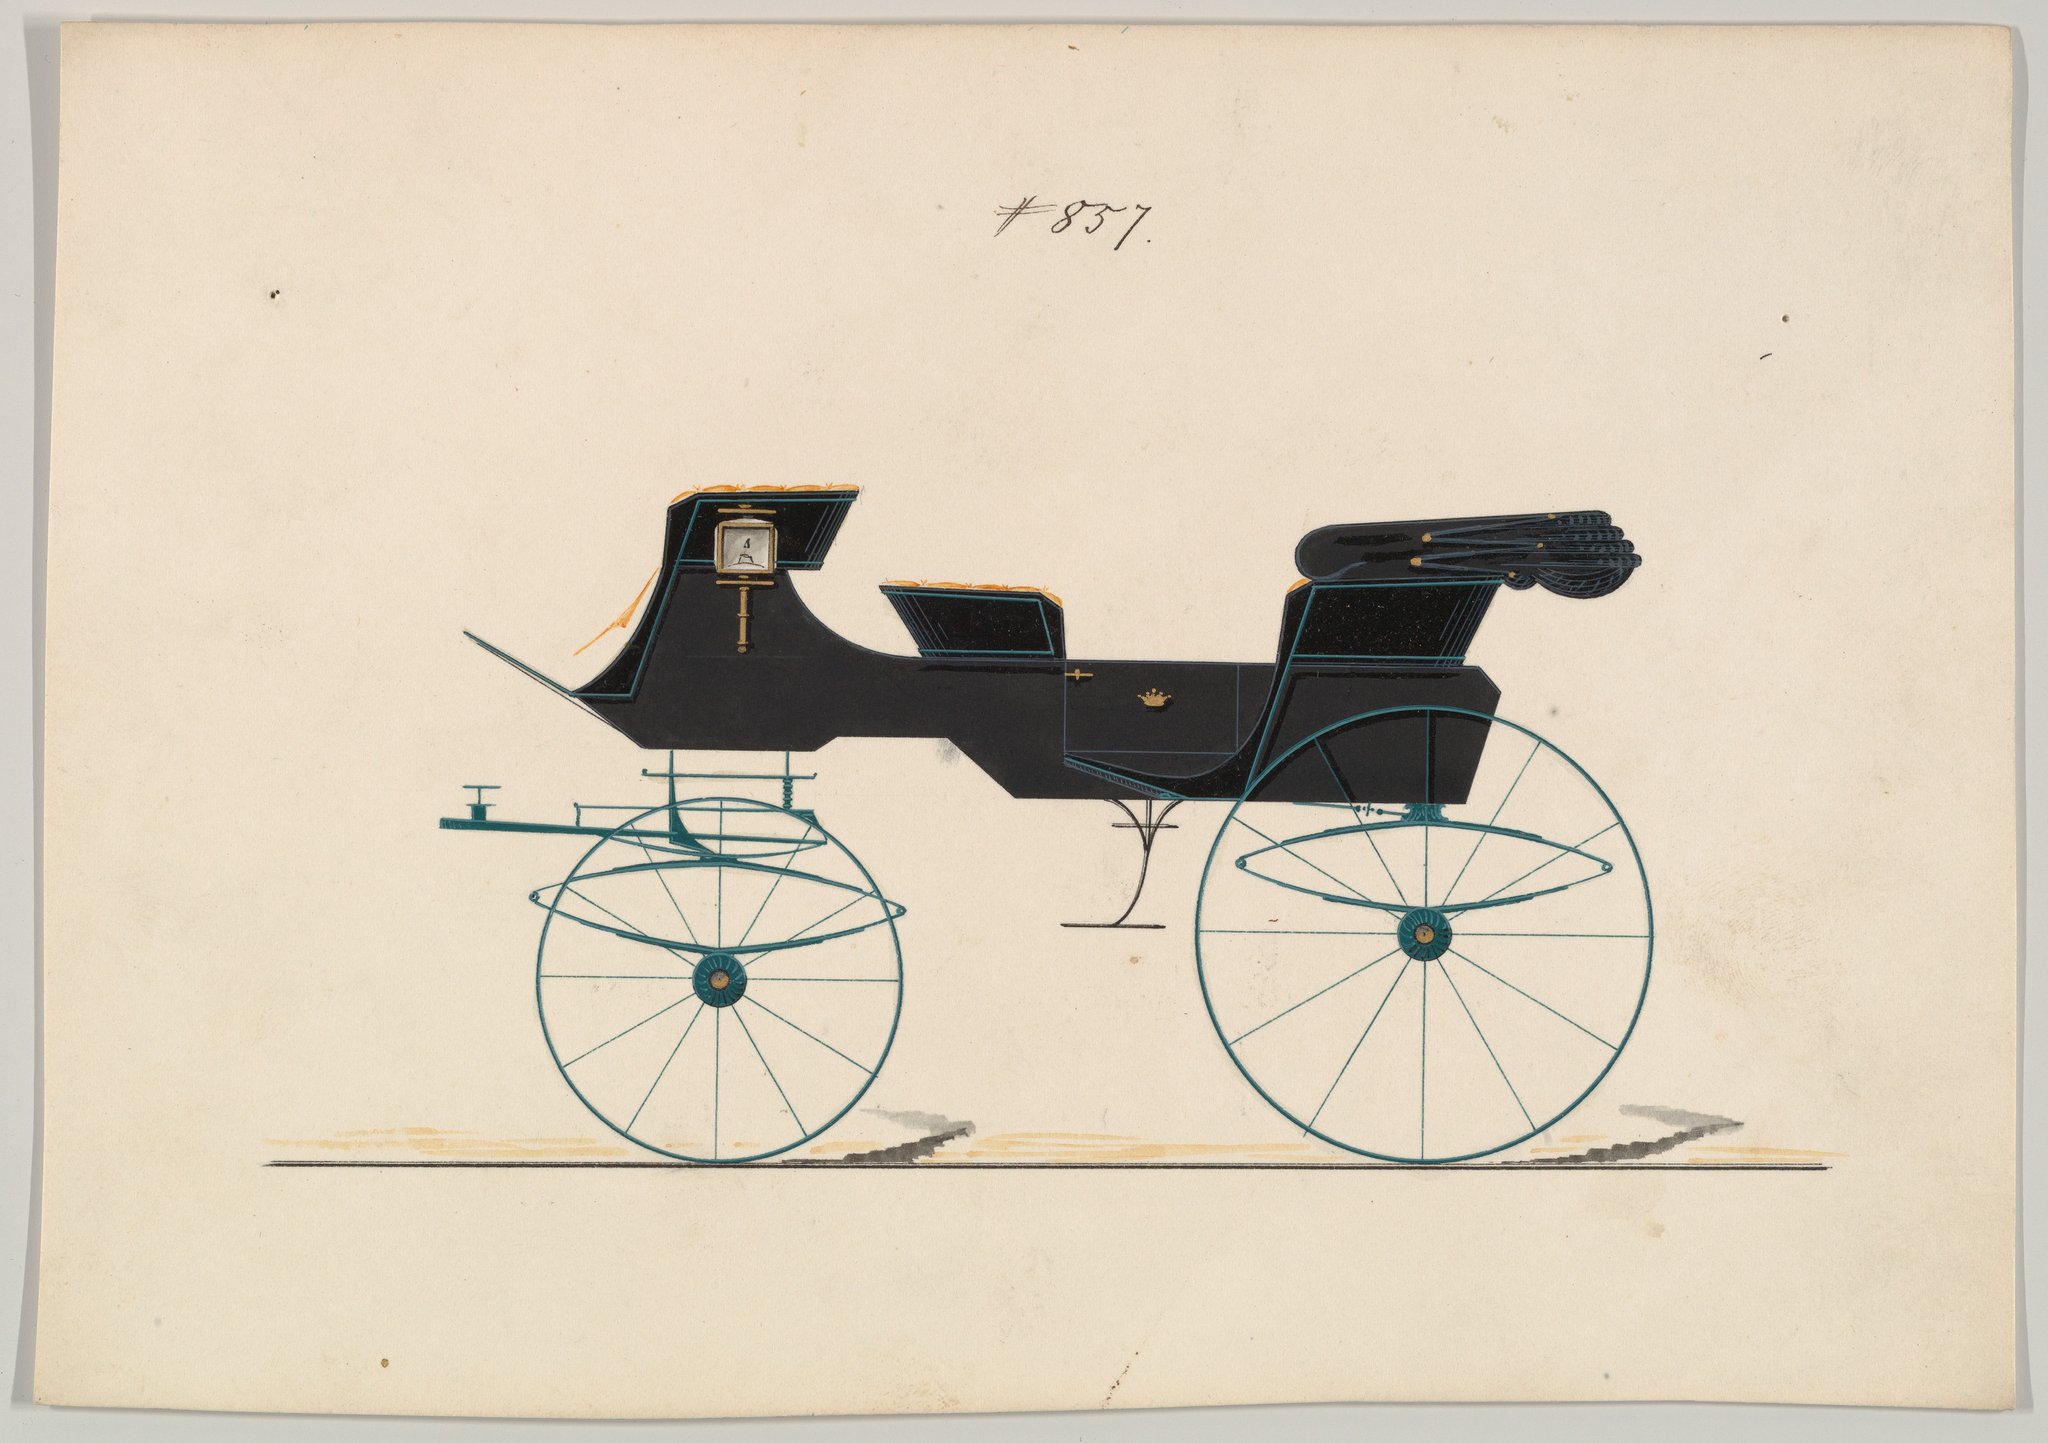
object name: drawing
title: Design for Vis-à-vis, no. 857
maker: brewster & co.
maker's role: manufacturer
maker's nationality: american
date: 1850-1870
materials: gouache, gum arabic, ink, watercolor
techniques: pen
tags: carriages